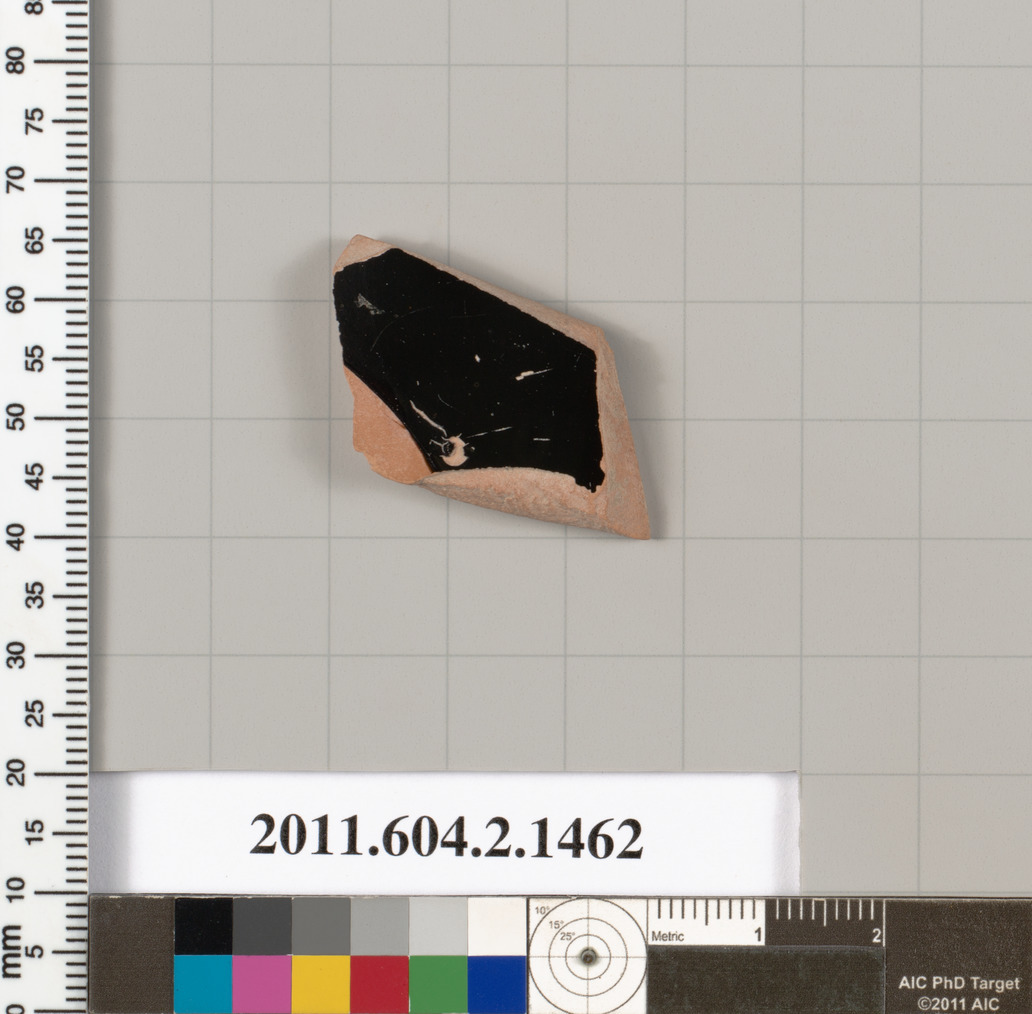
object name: skyphos fragment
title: Terracotta fragment of a skyphos (deep drinking cup)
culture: greek, attic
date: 475-451 BCE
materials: terracotta